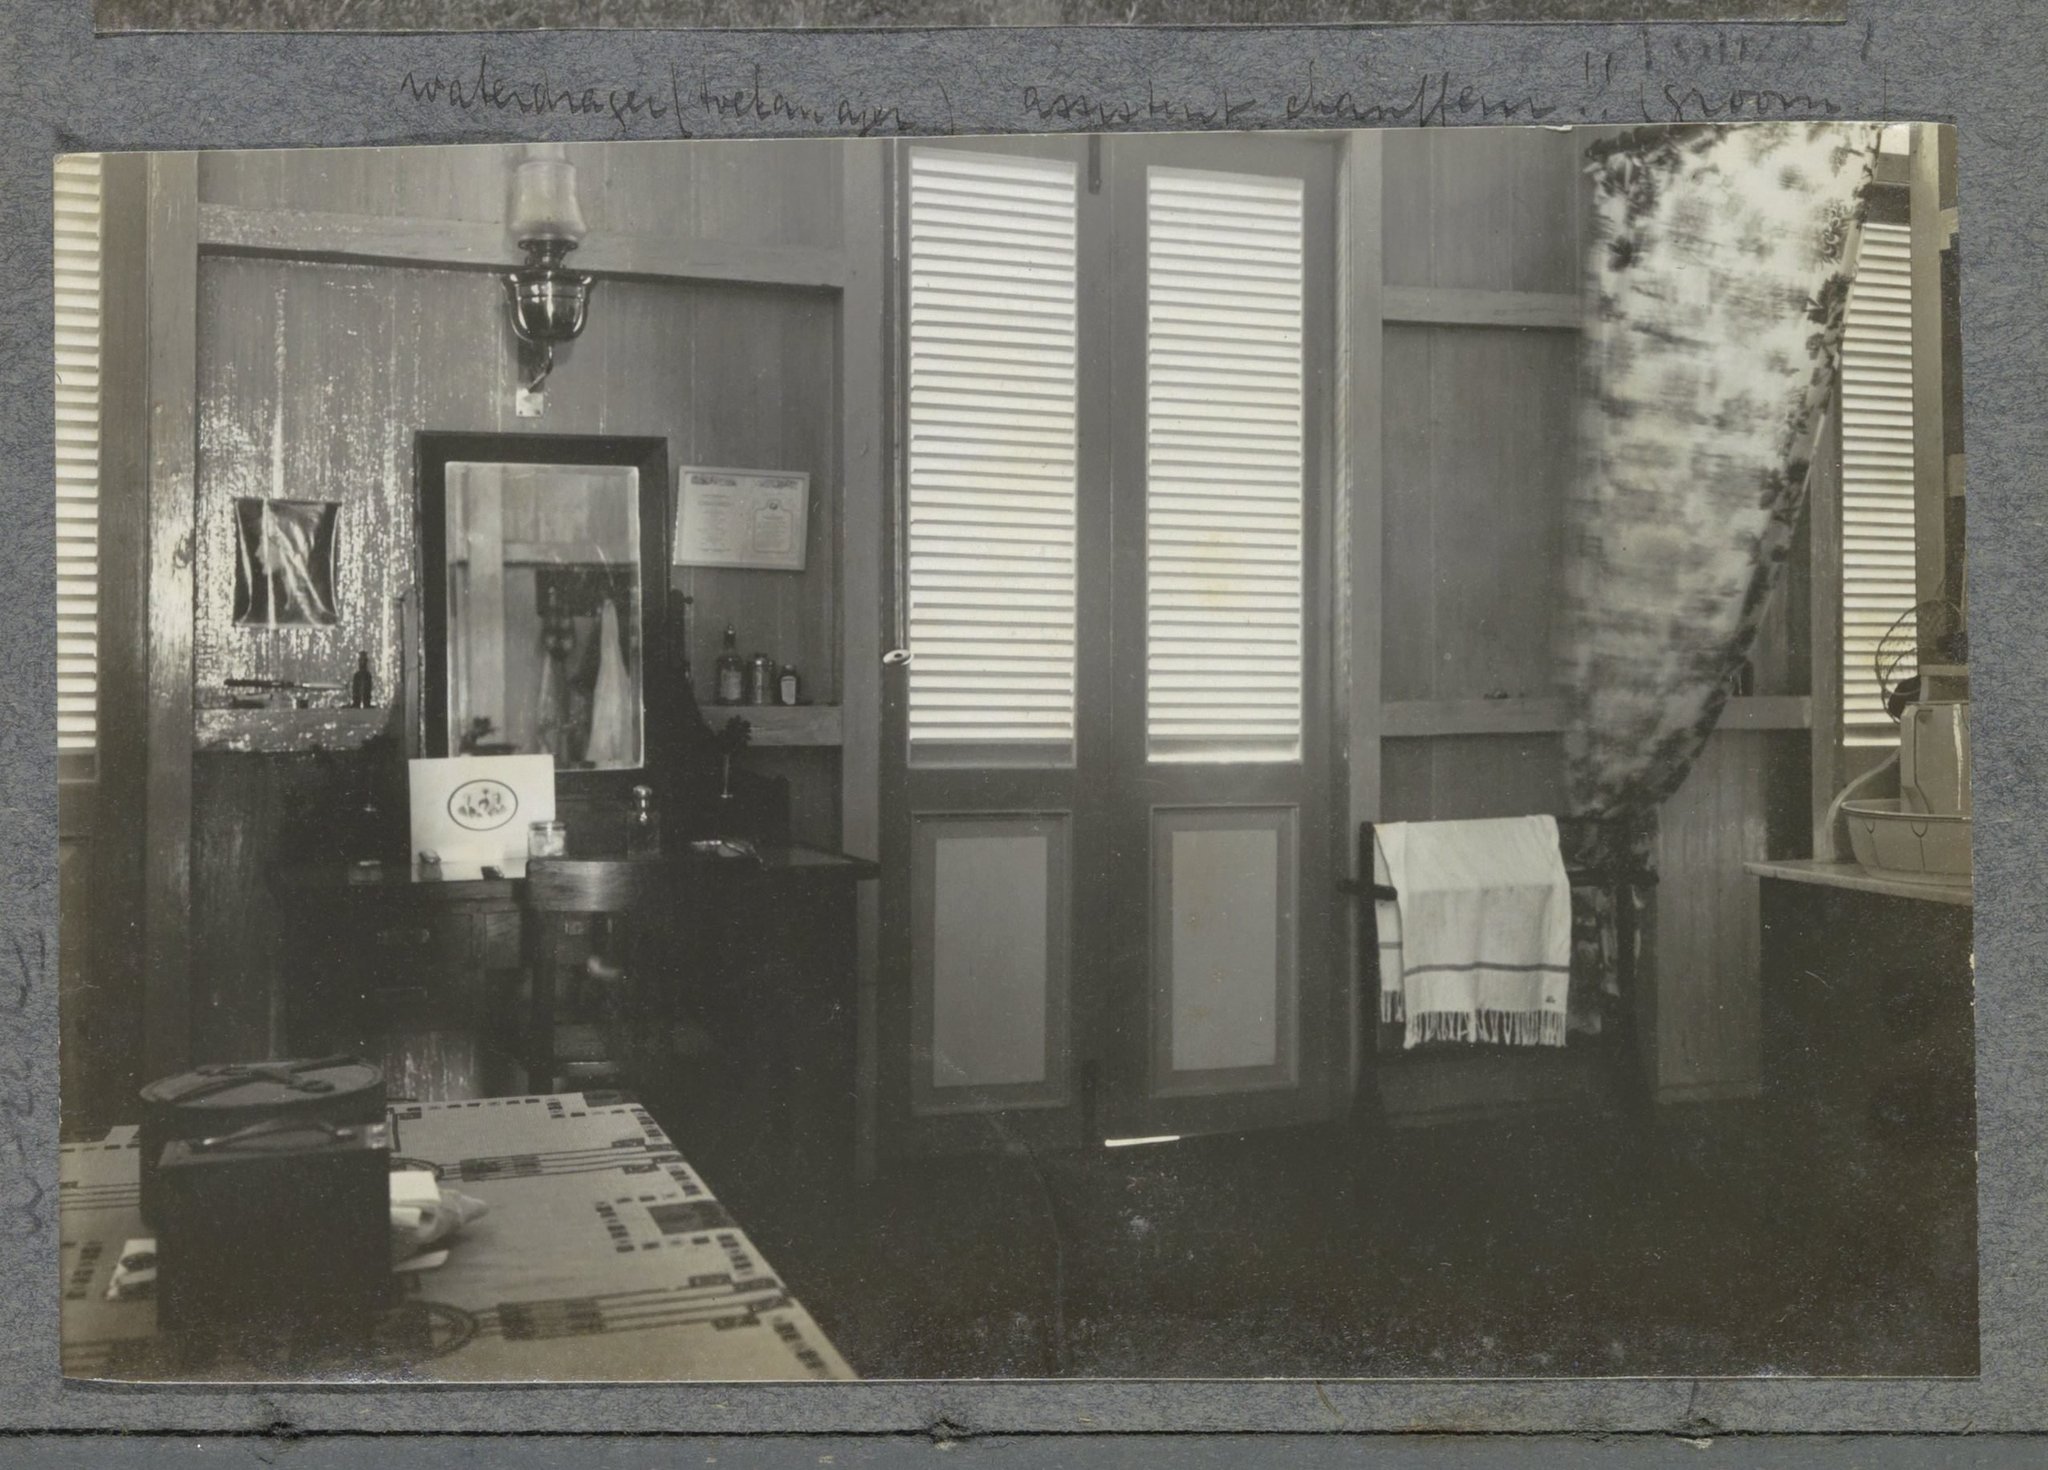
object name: photograph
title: Badkamer in woonhuis op Sumatra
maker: Anonymous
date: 1914-1926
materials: photographic support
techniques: gelatin silver print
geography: sumatra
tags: mirror, bathroom, sumatra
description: Onderdeel van fotoalbum met opnames van de familie Bergsma in Tandjong Poera en Rantan Pandjang (Sumatra).